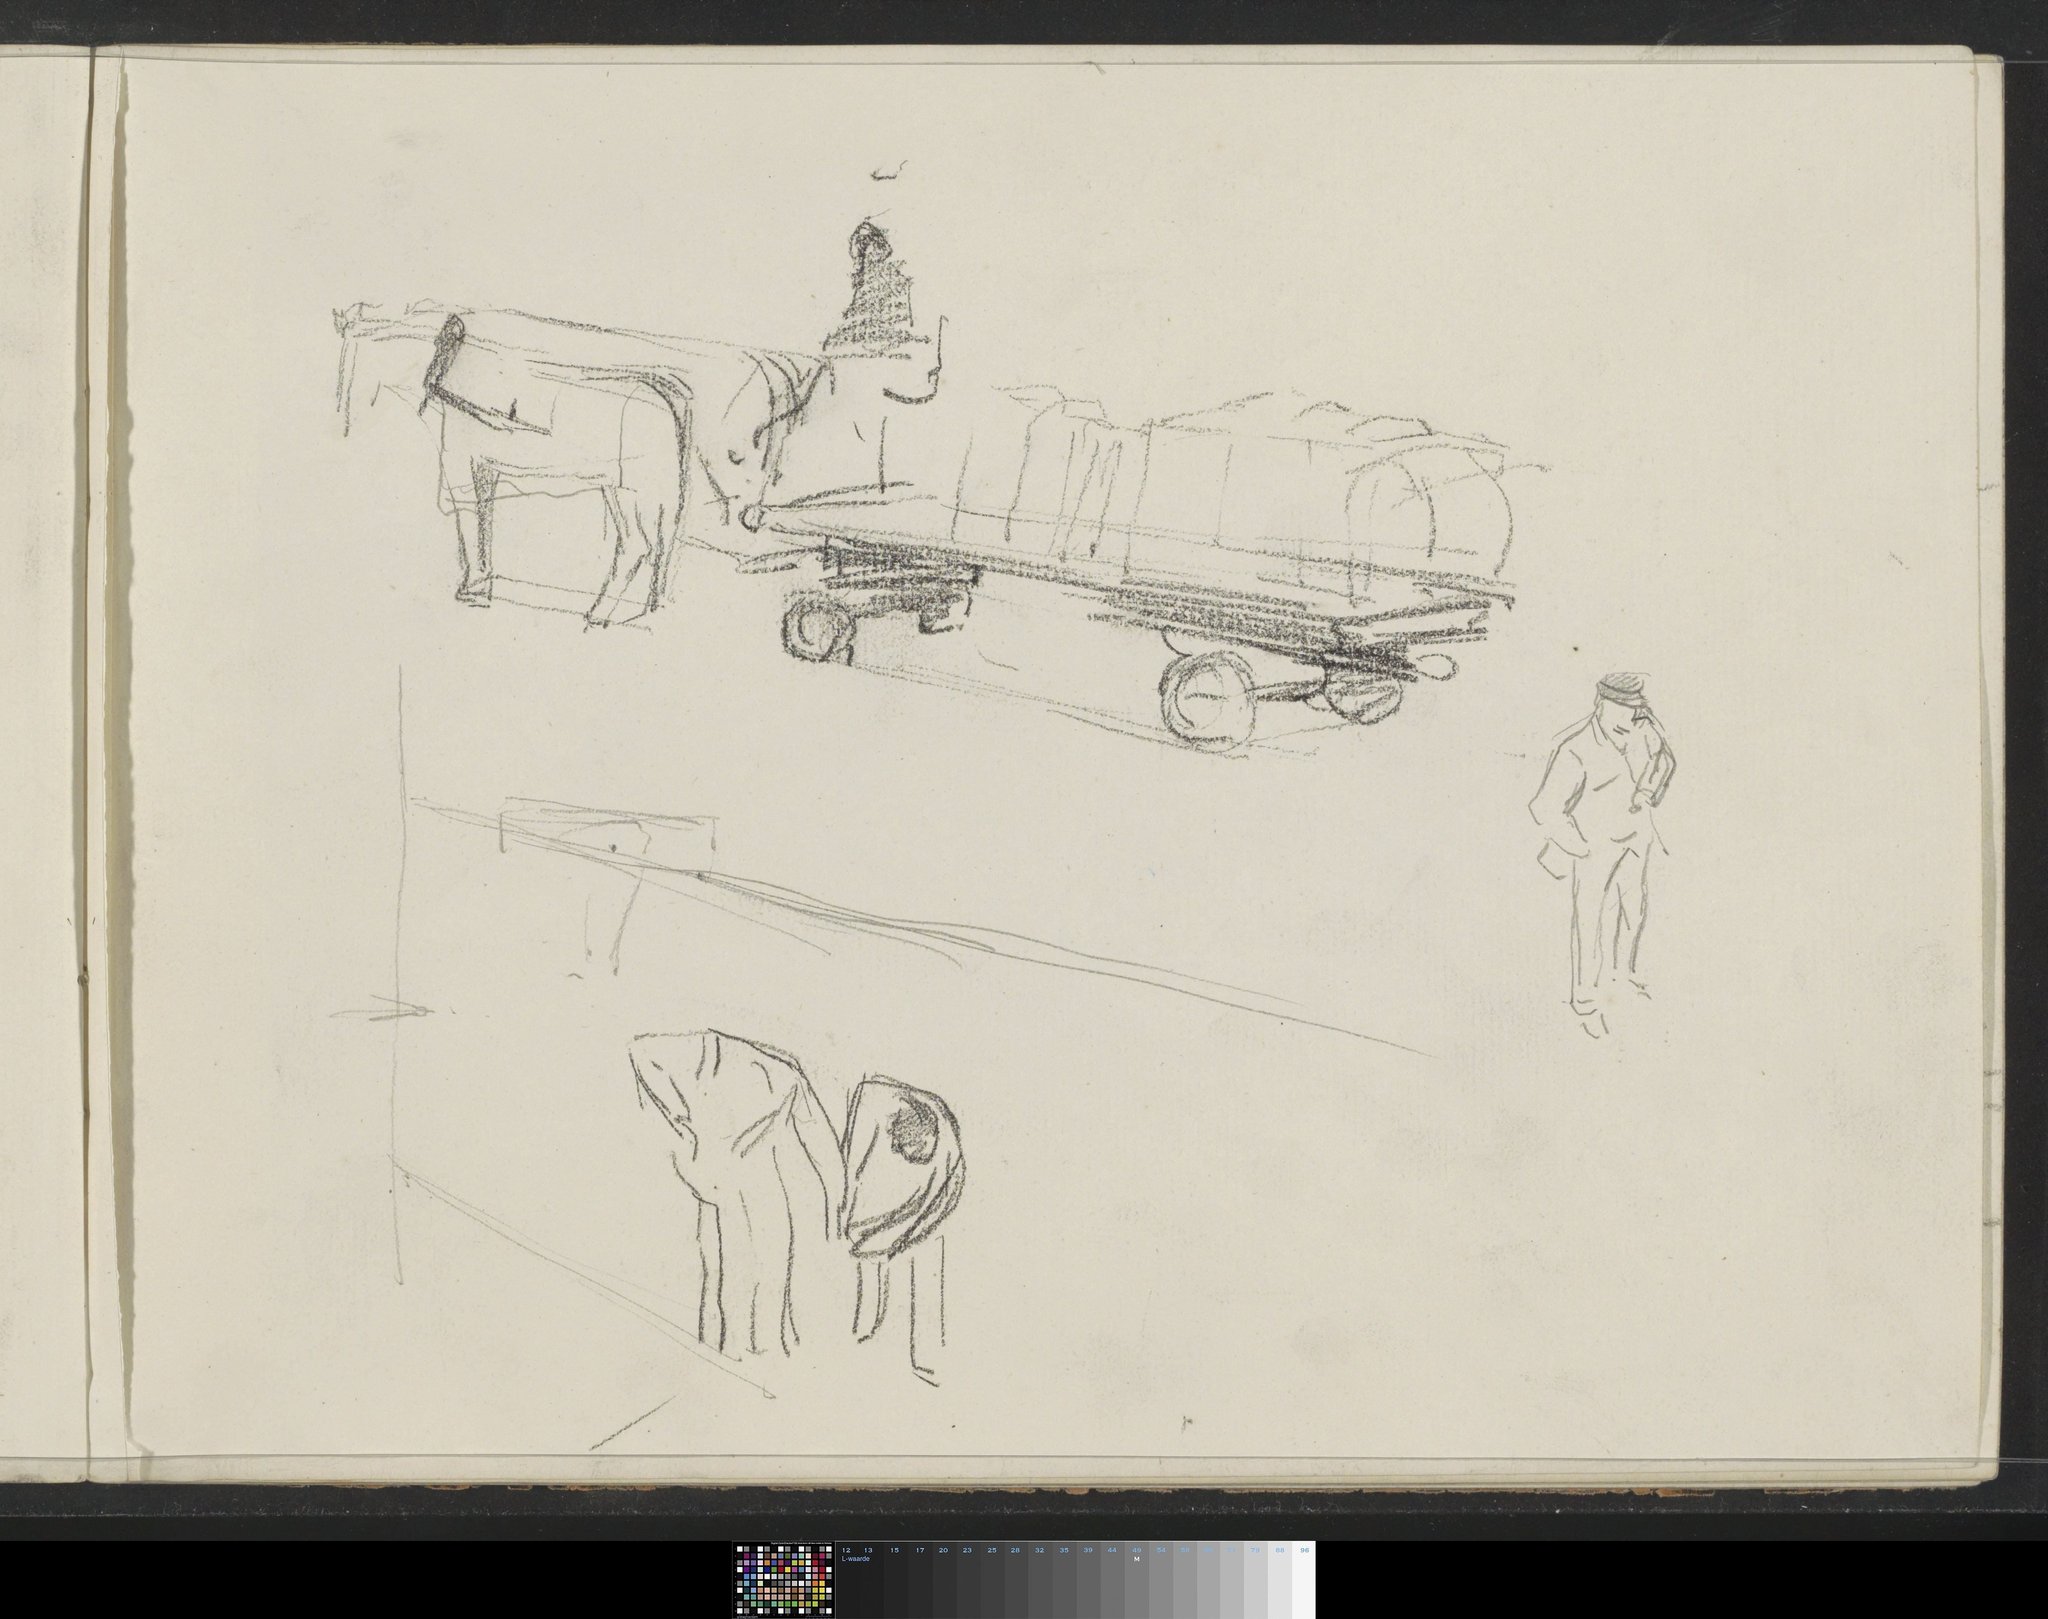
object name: sketchbook leaf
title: Transportwagen met een paard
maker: ferdinand oldewelt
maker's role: draughtsman, print maker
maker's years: 1857-1935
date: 1904-1912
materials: chalk, paper, pencil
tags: four-wheeled, animal-drawn vehicle, e.g.: cab, carriage, coach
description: Mogelijk is er meer dan één paard voor de wagen gespannen. Tevens een studie van een staande man met een pet. Blad 9 recto uit een schetsboek met 27 bladen.